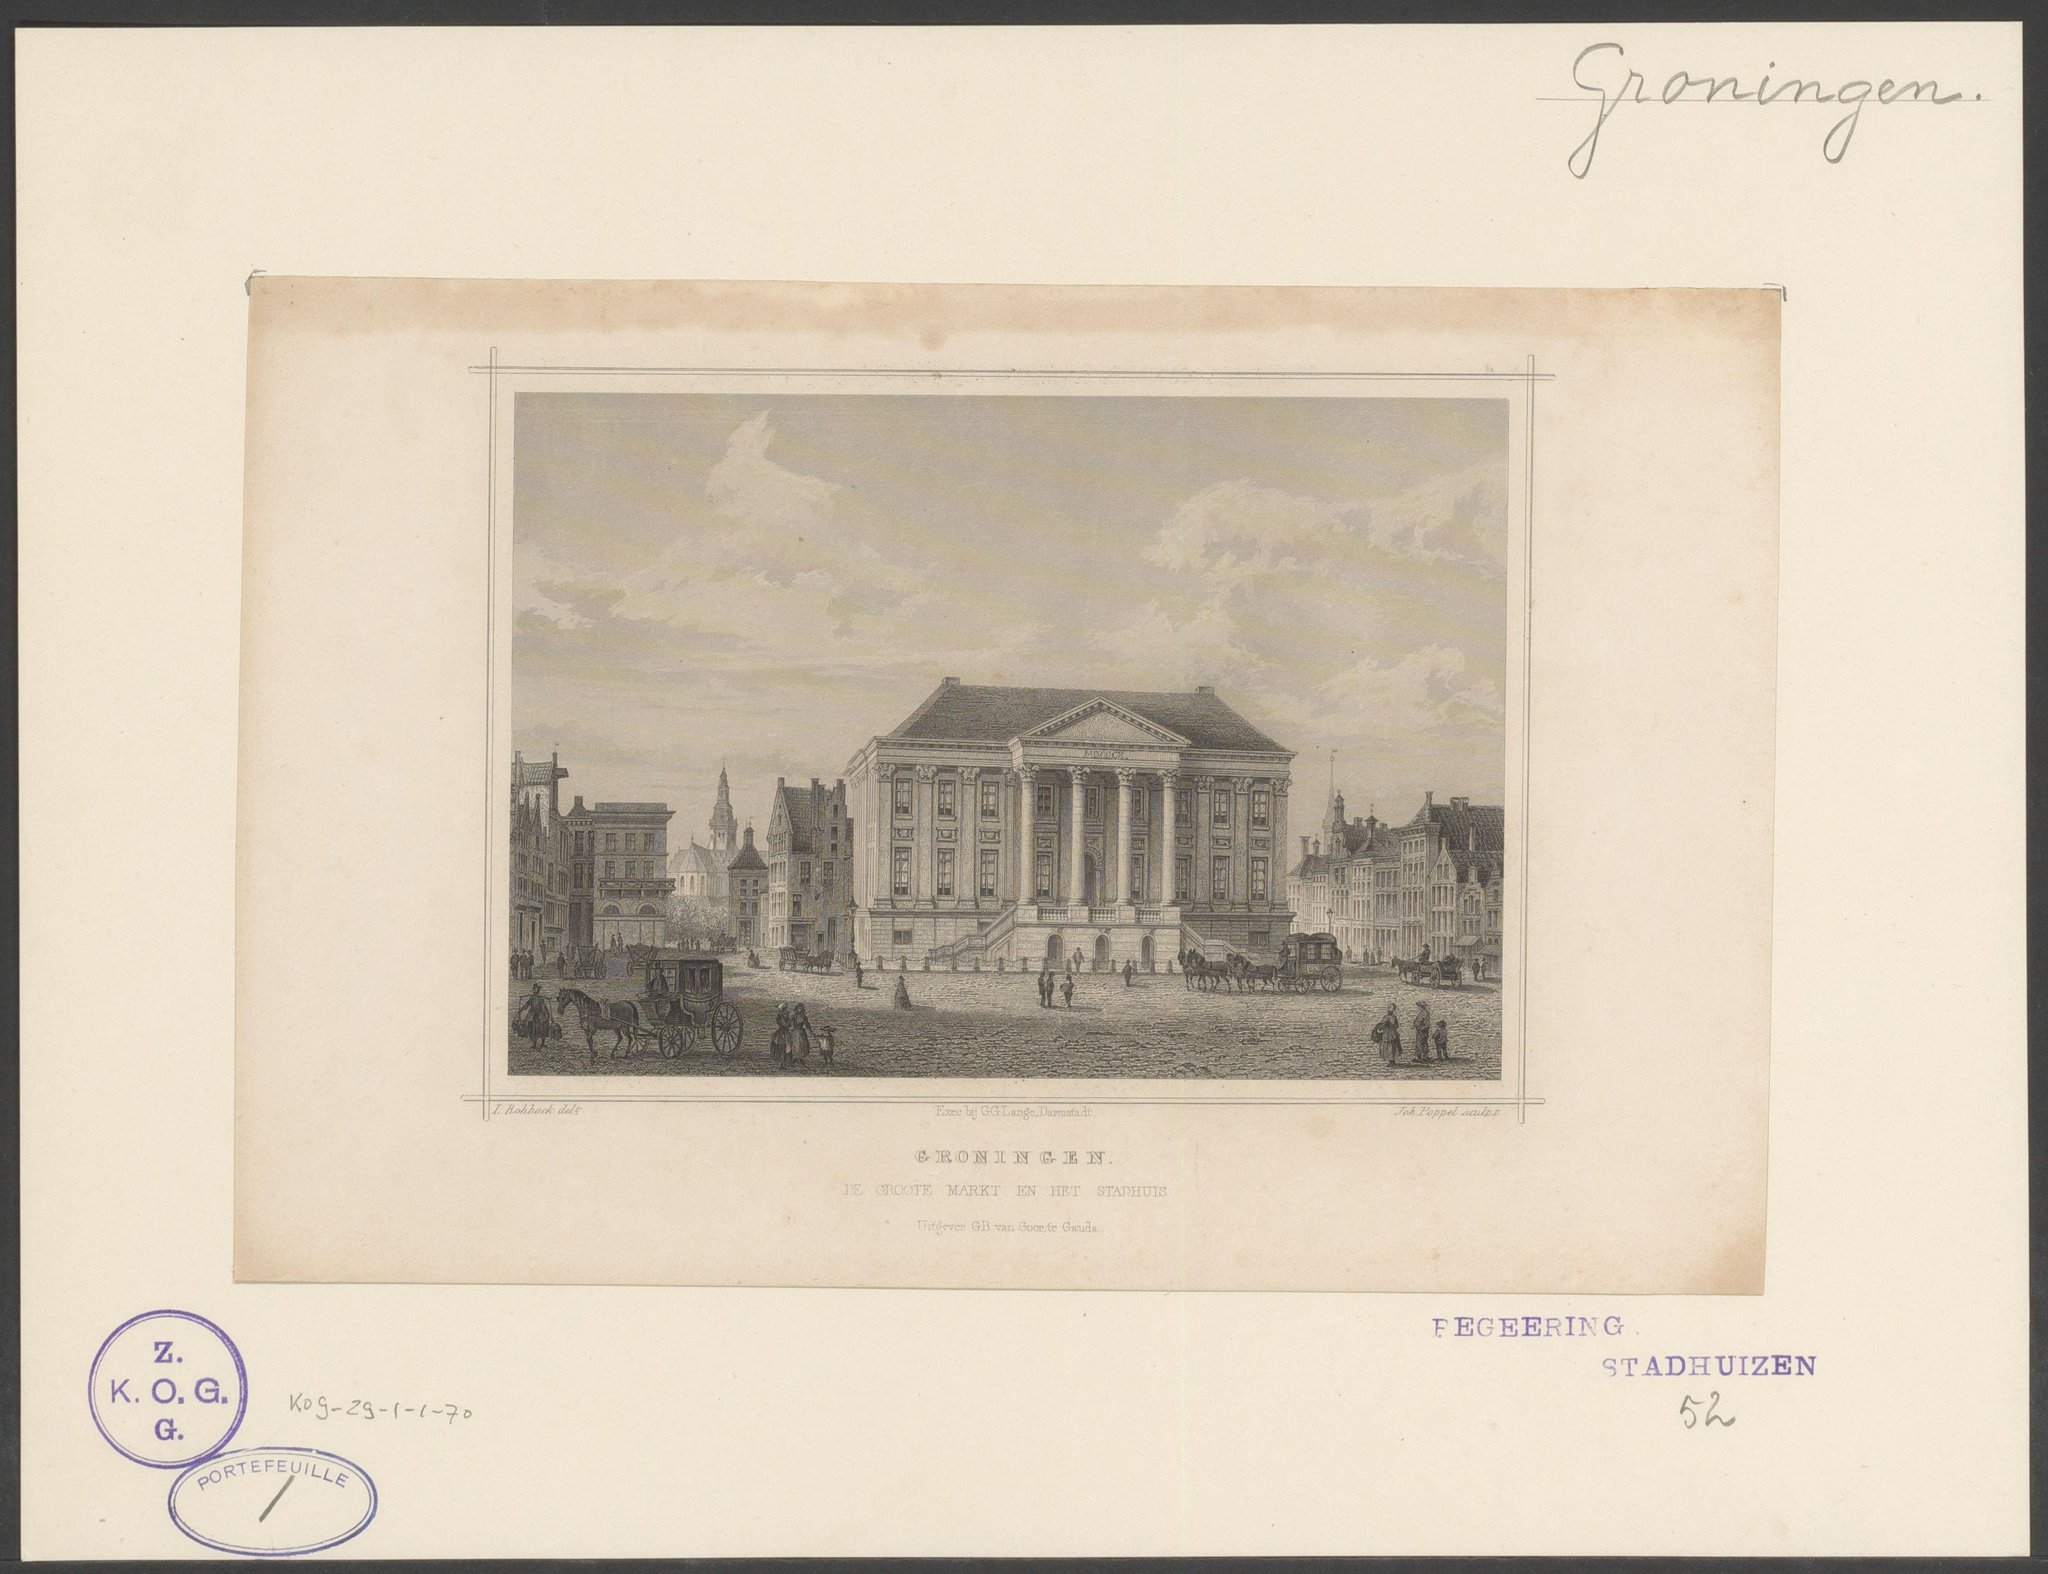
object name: book illustration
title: Groningen. De Groote Markt en het Stadhuis.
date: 1855-1857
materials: paper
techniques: engraving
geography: gouda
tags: townhall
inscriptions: collector's mark, collector's mark: Lugt 1641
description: Prent uit: Terwen, J.L. Het koningrijk der Nederlanden (...). 2 dln. Gouda: G.B. van Goor, 1857. Dezelfde prent, met een ander onderschrift, komt ook voor in: Der Rhein und die Rheinlande in malerischen Original-ansichten. 3 dln. Darmstadt: G.G. Lange, 1863.